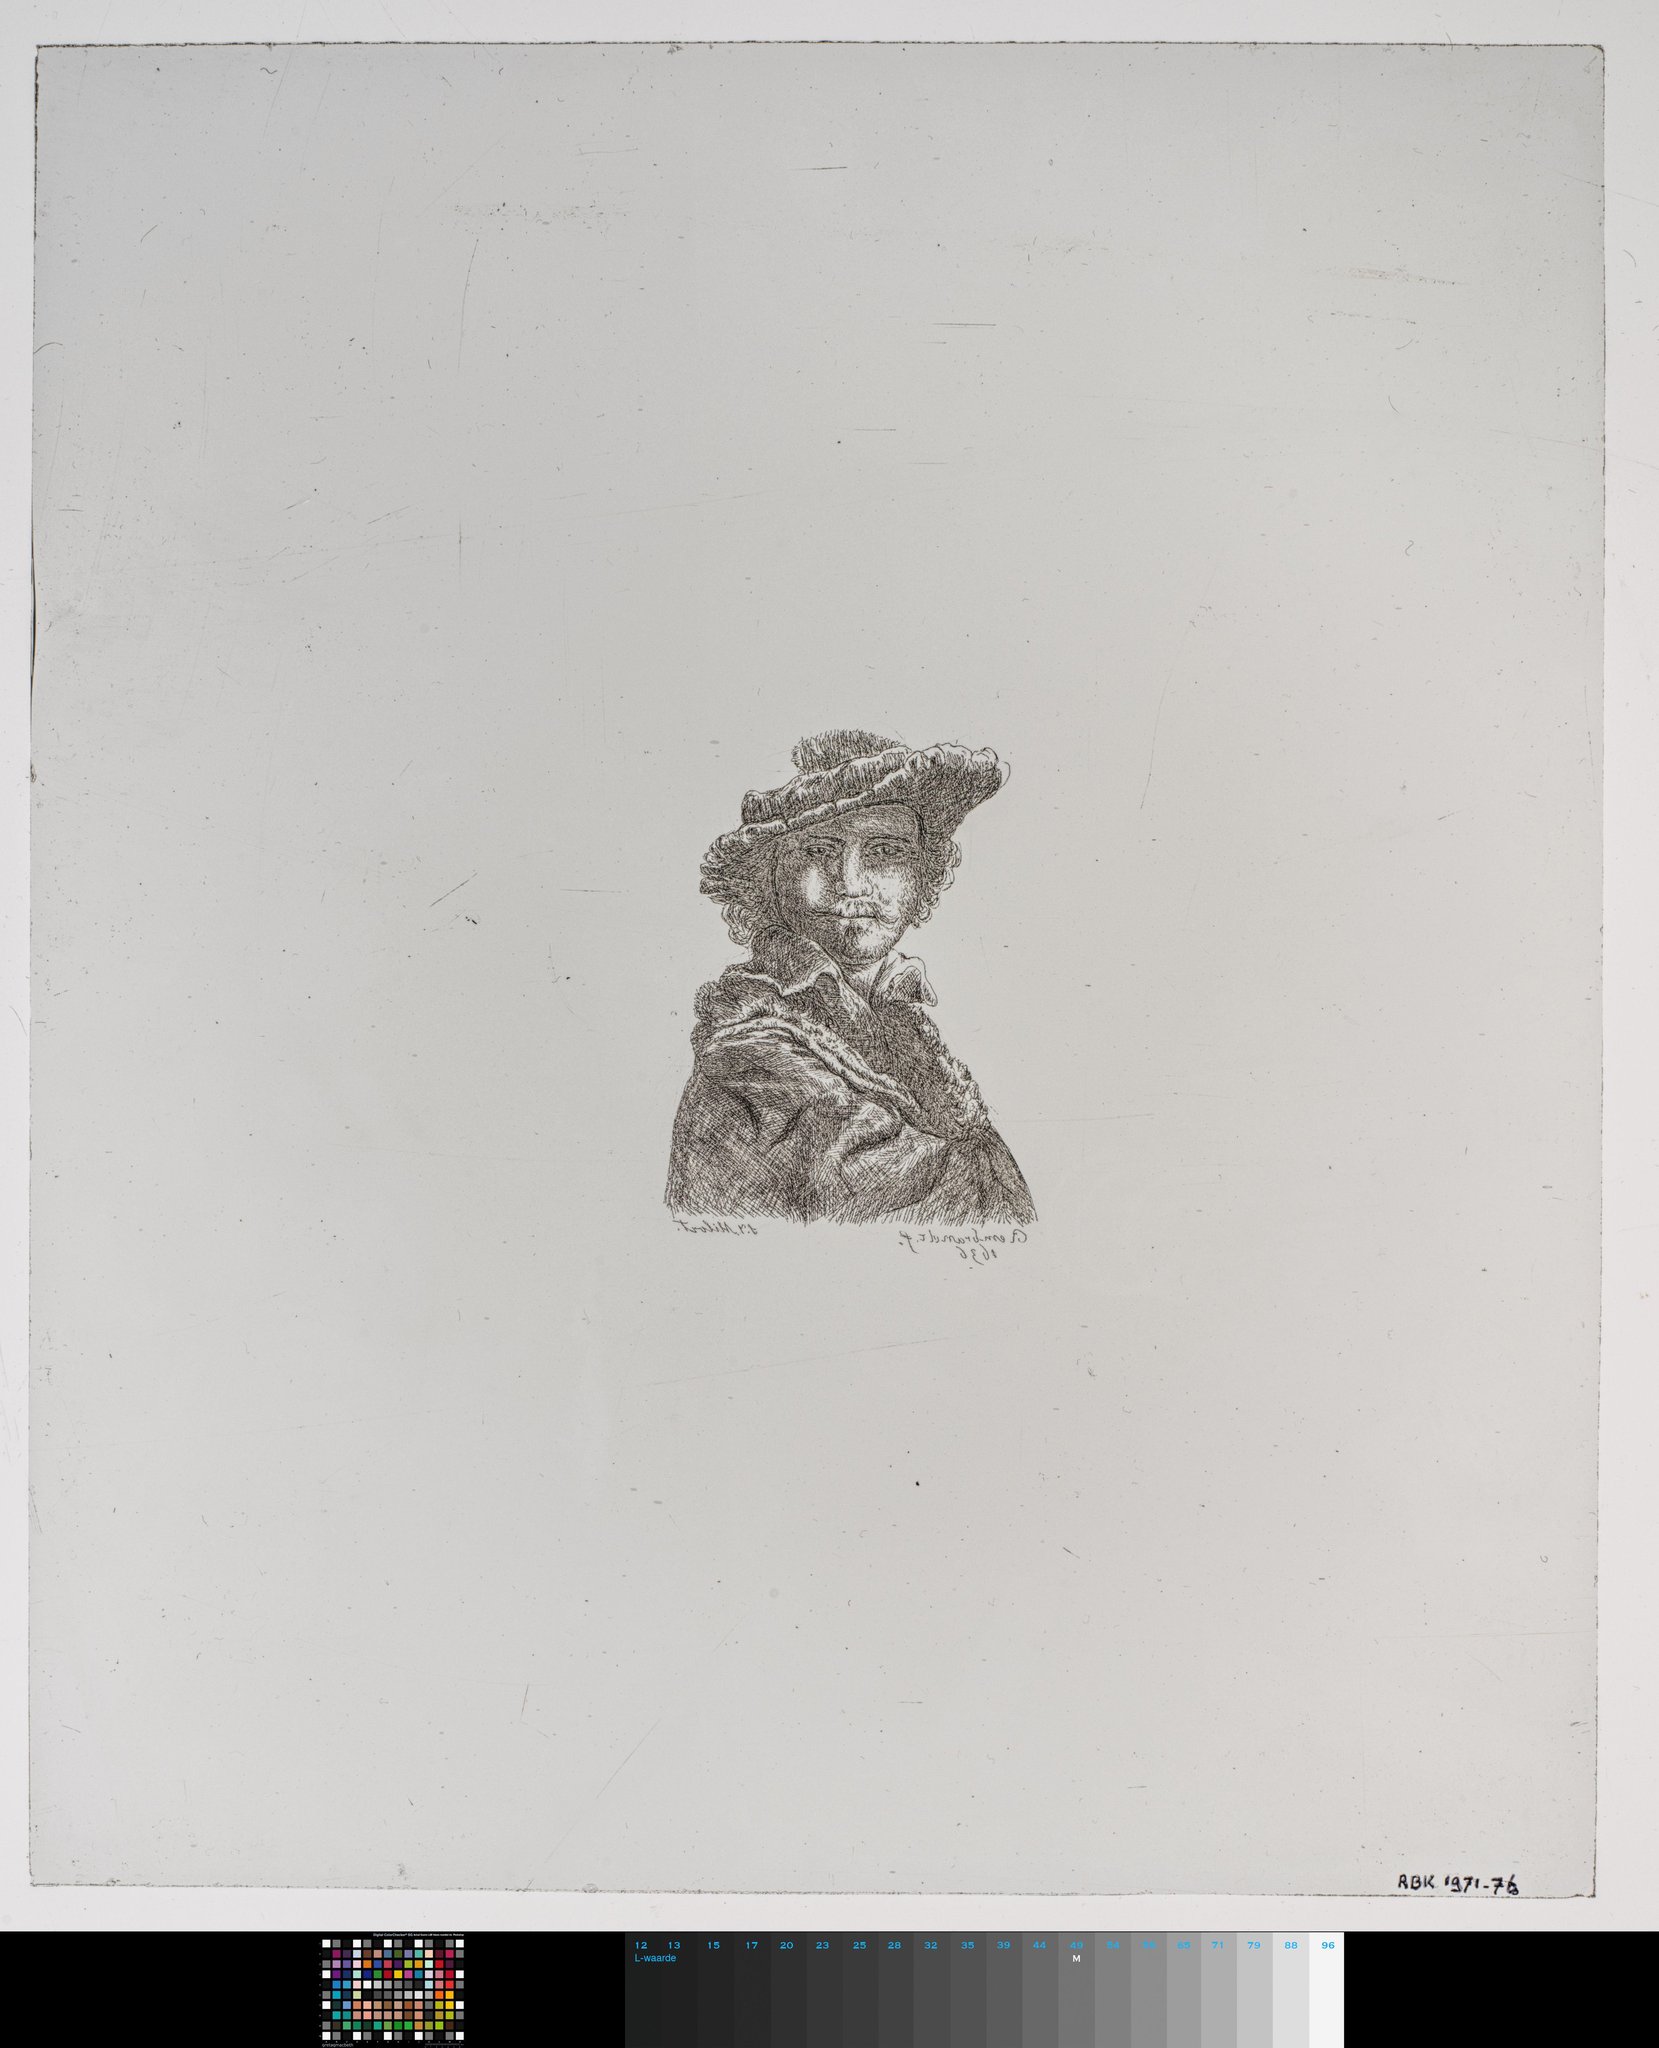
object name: light window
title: Ruit met een portret van Rembrandt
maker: servatius johannes melort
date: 1850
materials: glass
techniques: diamond point engraving, engraving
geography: netherlands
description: Rechthoekige ruit, waarop is gegraveerd een portret van Rembrandt. Links onder het portret Rembrandt. f. 1636, rechts onder de signatuur S.J. Milort.